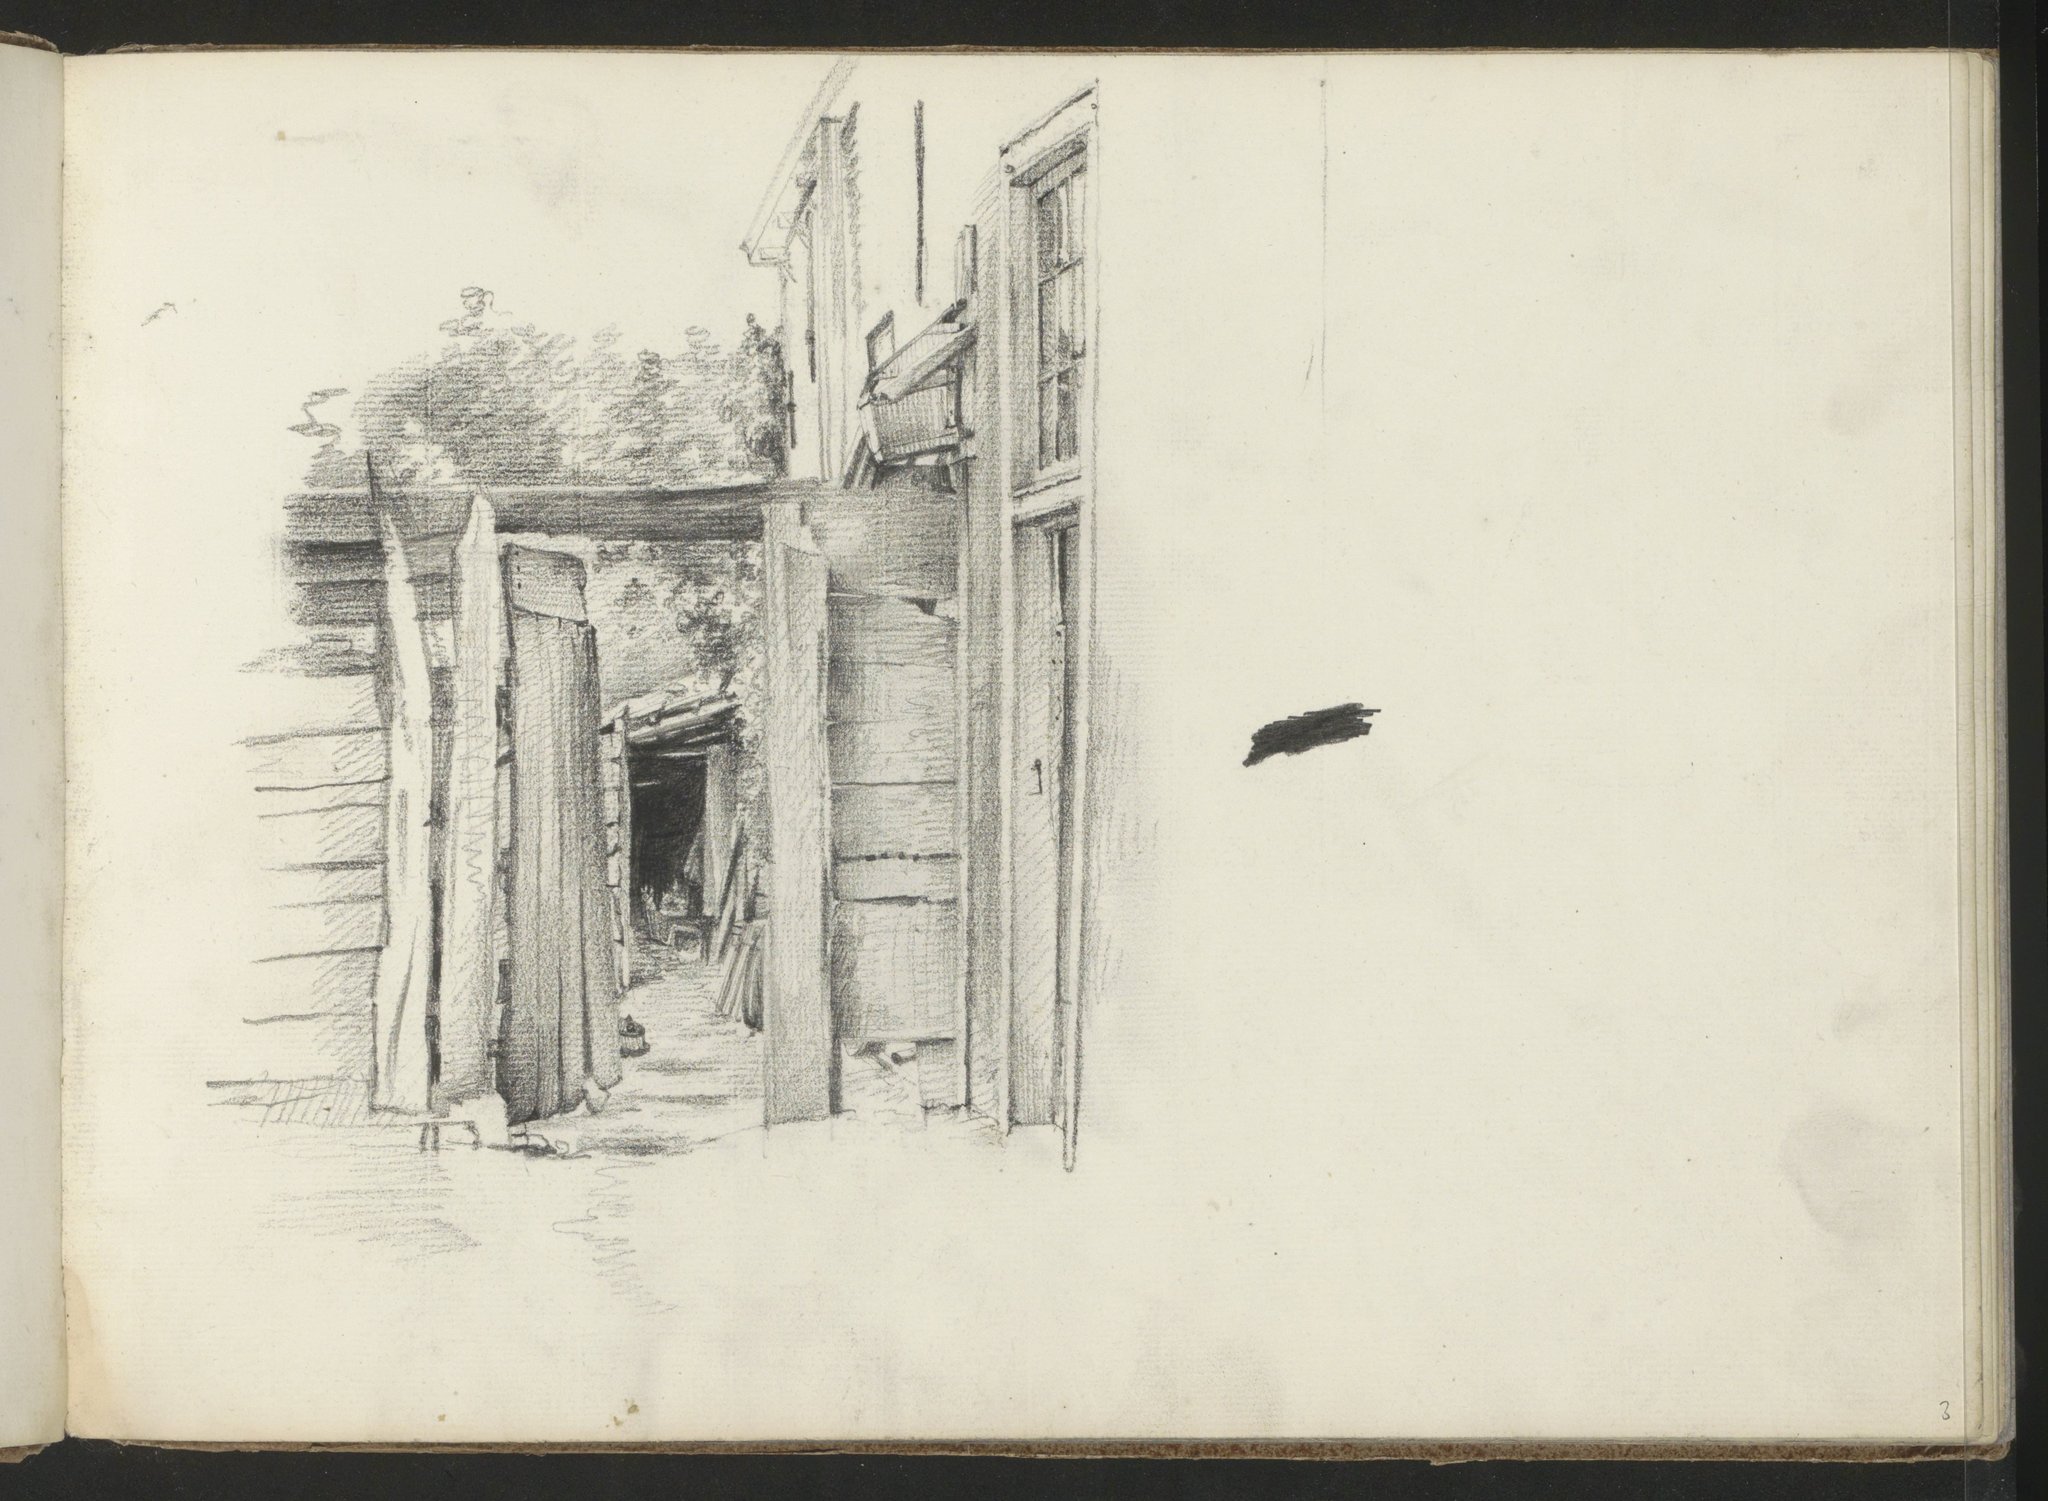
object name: sketchbook leaf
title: Schutting met een deur op een achterplaats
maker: s. altmann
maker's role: painter, print maker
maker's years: 1822-1890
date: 1803-1840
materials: paper, pencil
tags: fence, wall, paling, shed, backyard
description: Door de open deur in de schutting is een schuur te zien. Blad 3 recto uit een schetsboek met 24 bladen.